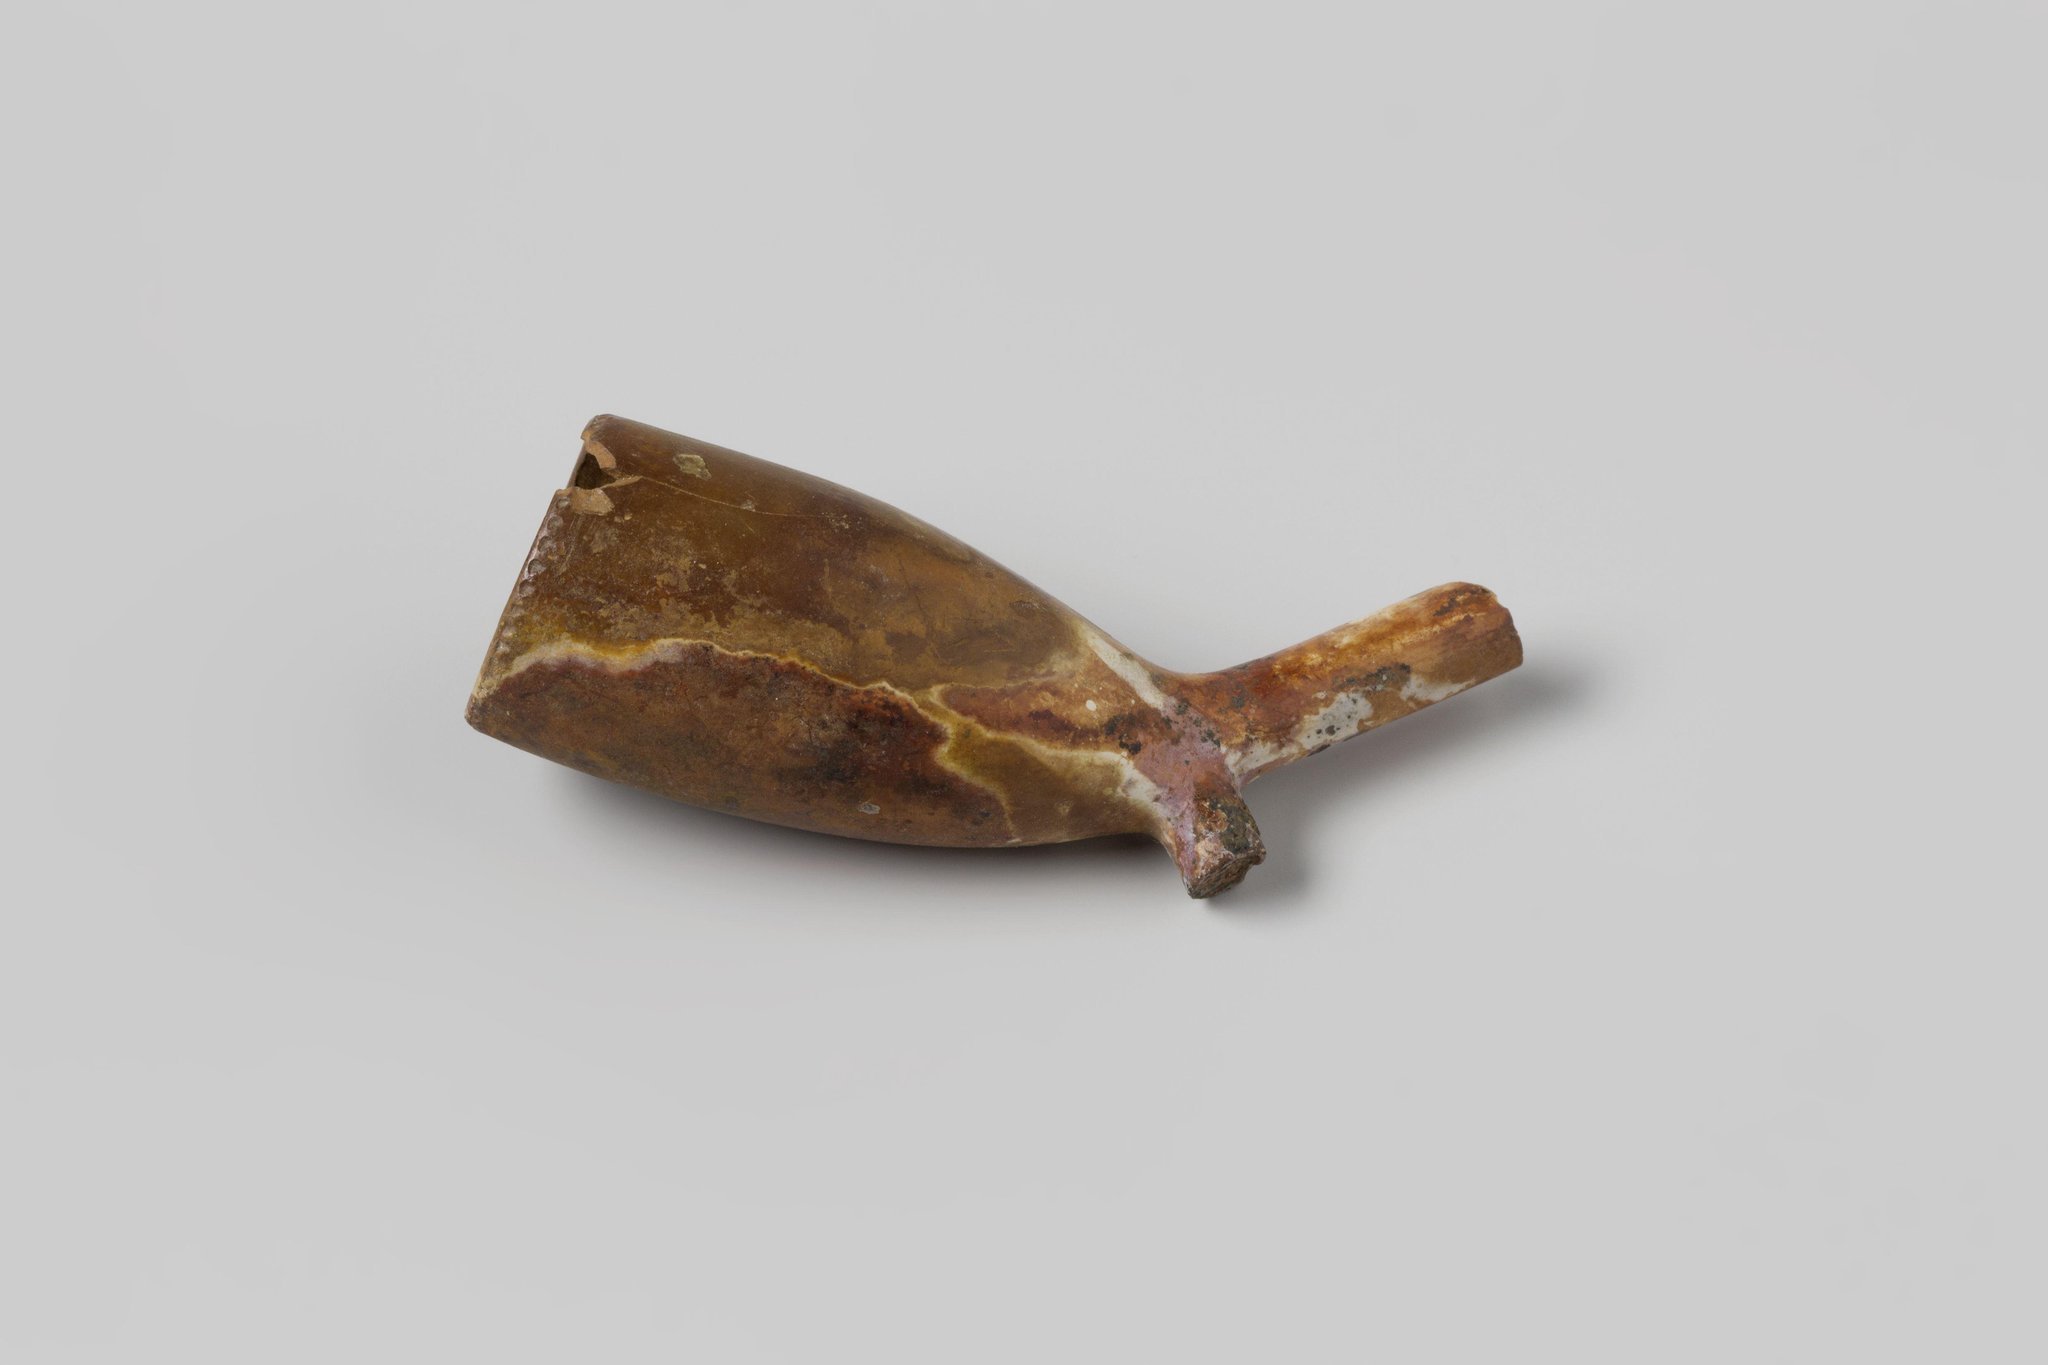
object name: pipe bowl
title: Pijpenkop met stuk steel uit het wrak van de Oost-Indiëvaarder Hollandia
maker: Anonymous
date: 1700-1743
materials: clay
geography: netherlands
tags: verenigde oostindische compagnie, hollandia (schip), annet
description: Pipe, bowl, heelmark: coat of arms of the province of Gelderland; no hsm.